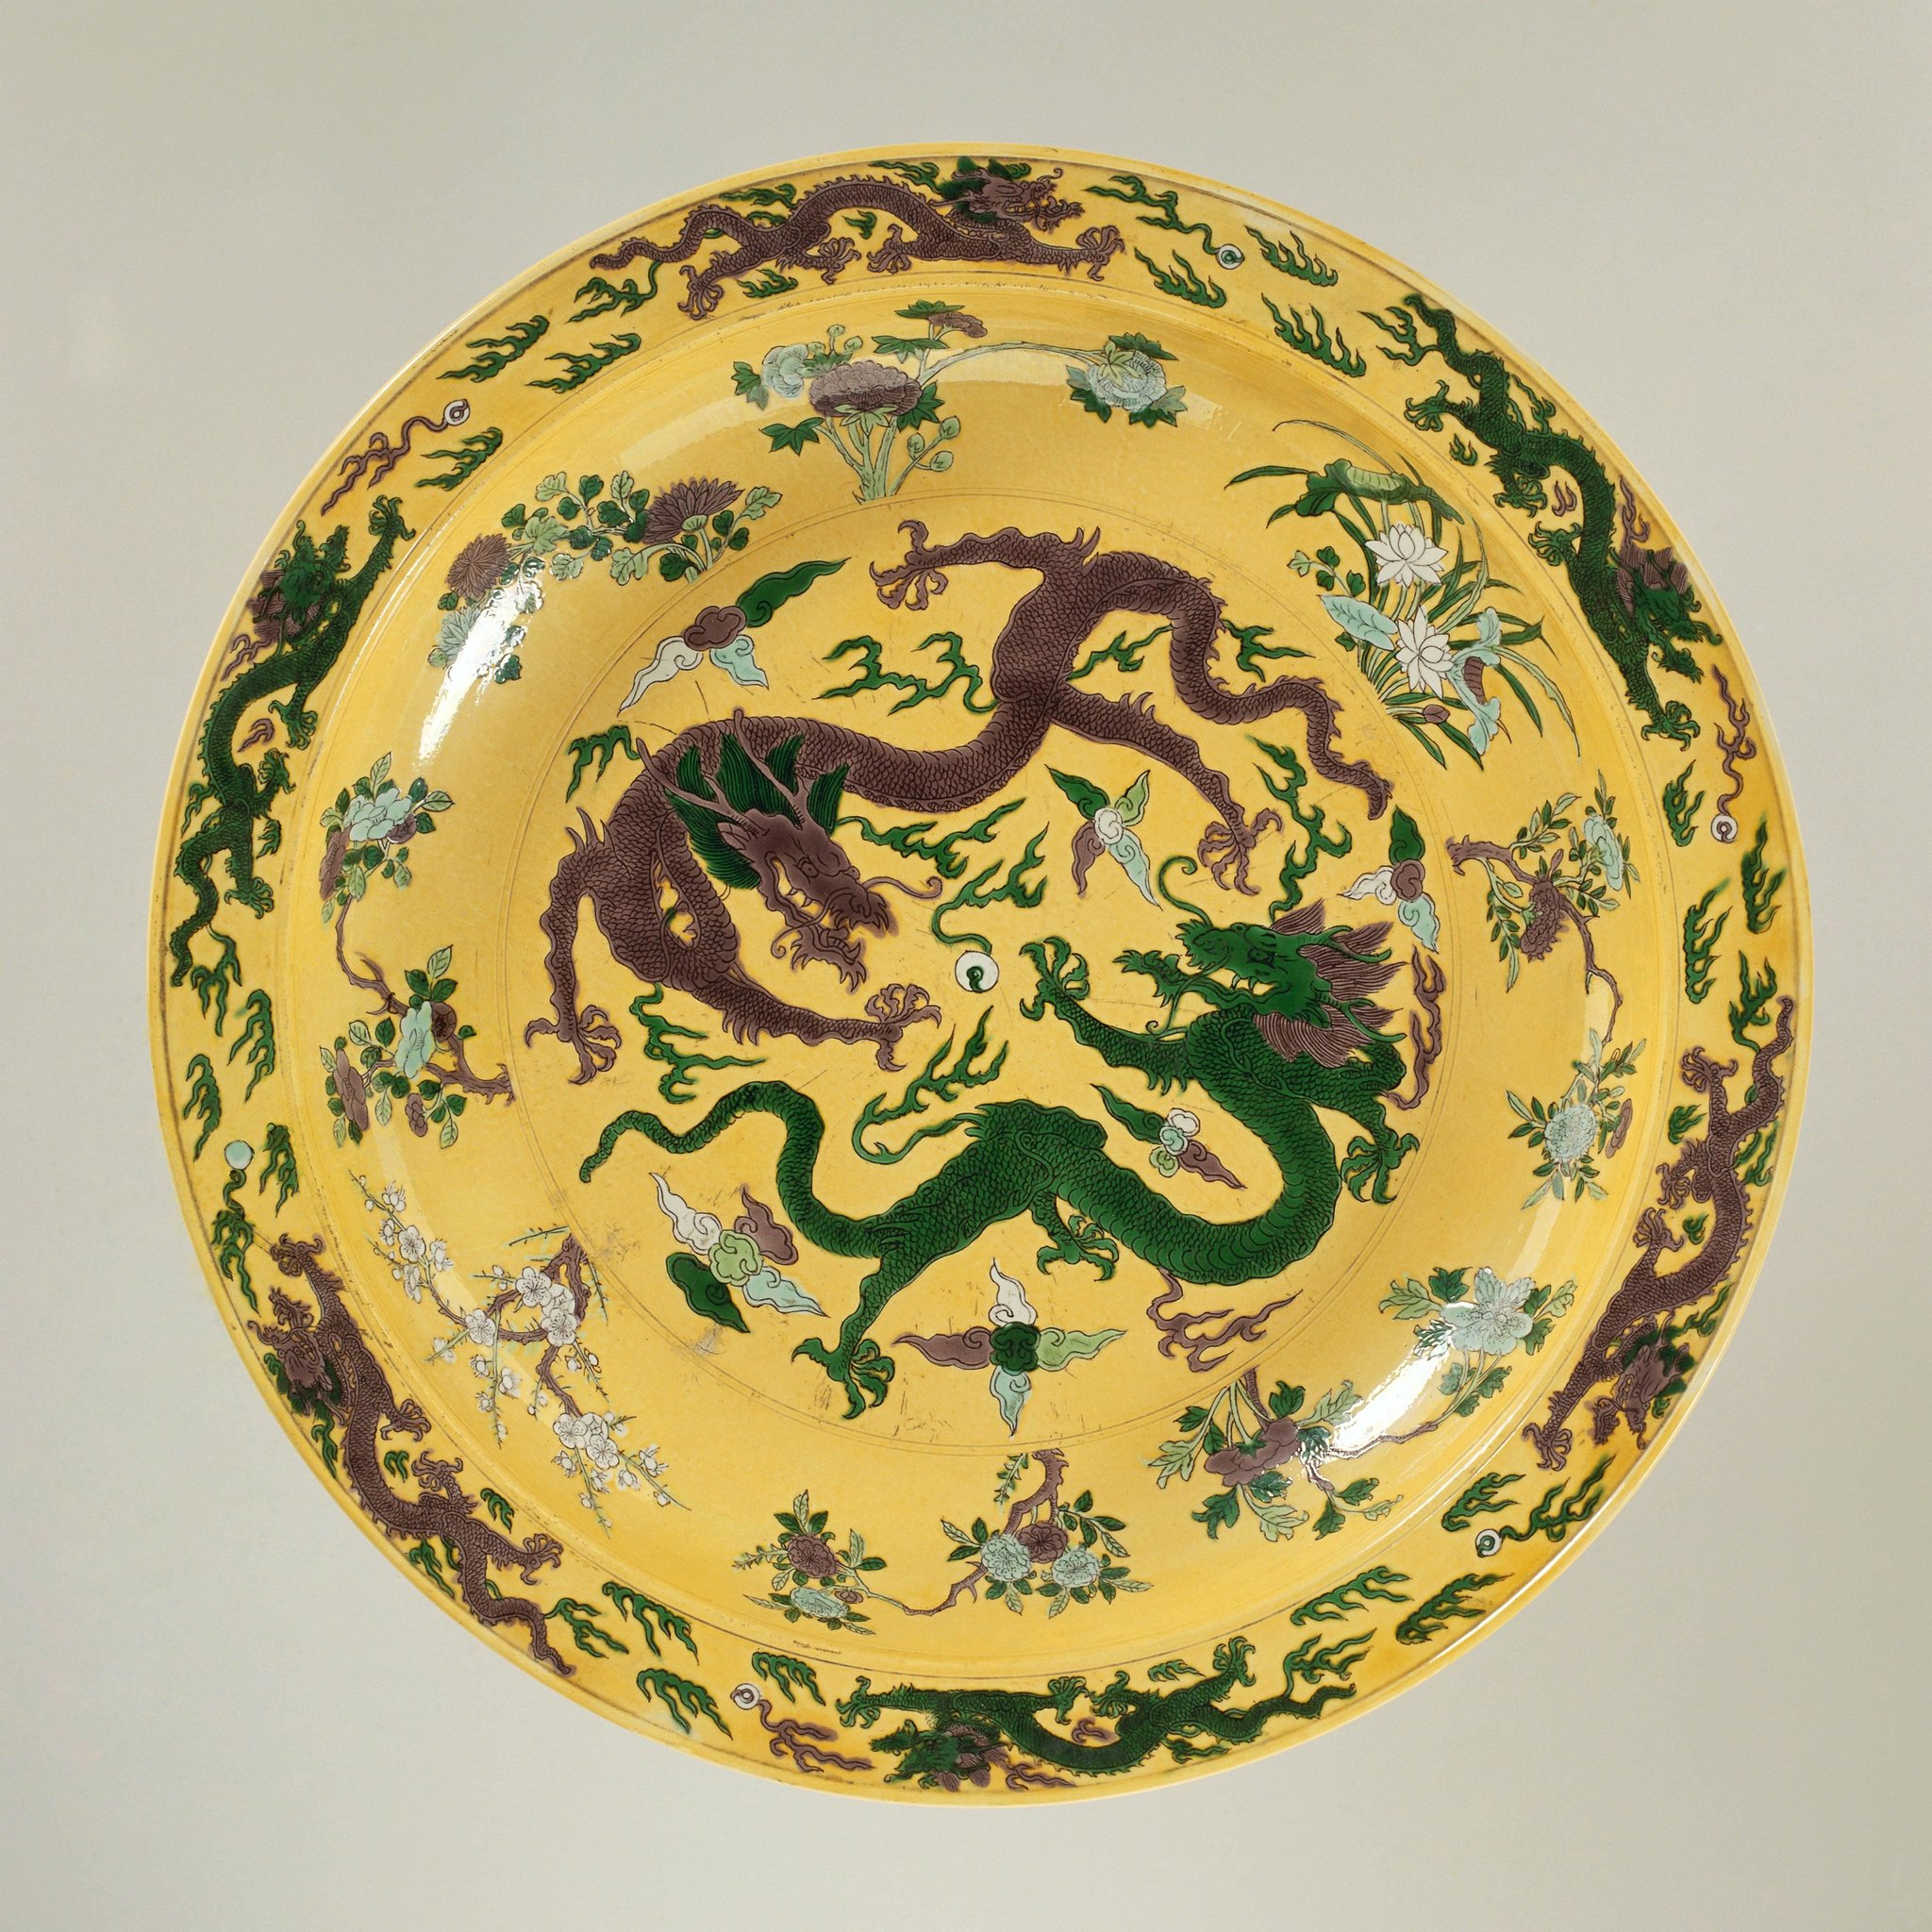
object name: platter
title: Dish with pearl chasing dragons on a yellow ground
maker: Anonymous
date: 1850-1900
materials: glaze, paint, porcelain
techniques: firing, turning, vitrification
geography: china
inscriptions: mark: ‘大 清 康 熙 年 製 dà qīng Kāng xī nián zhì’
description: Bord, famille jaune, twee ingegrifte draken die de parel najagen omgeven door wolken en dondermotieven.